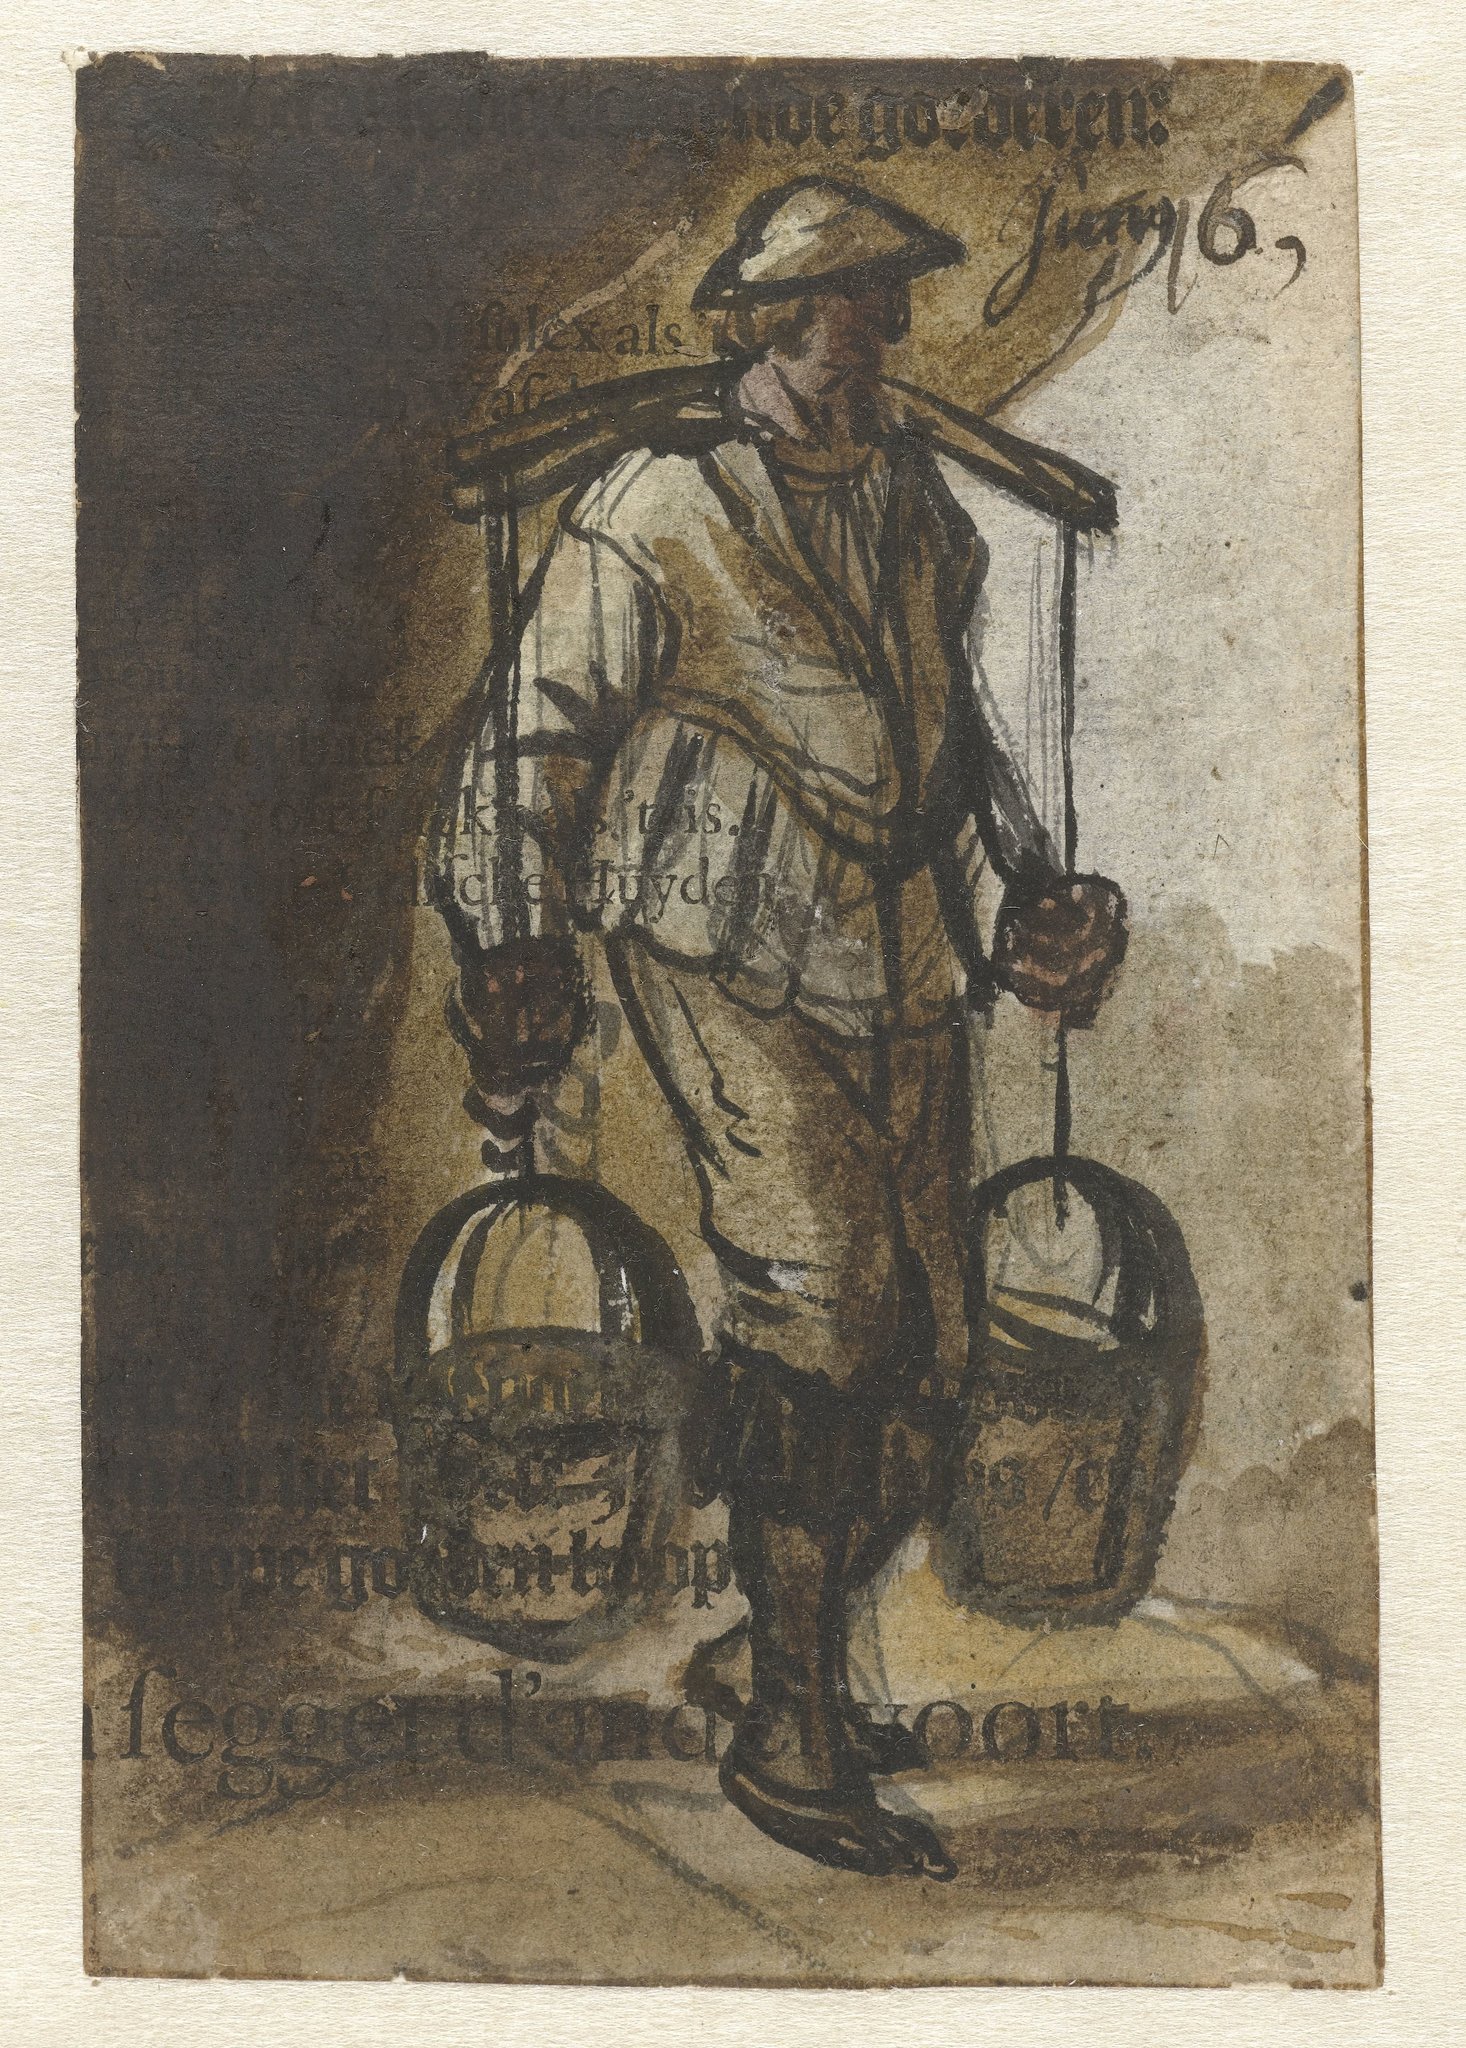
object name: drawing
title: De twaalf maanden van het jaar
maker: Anonymous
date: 1600-1699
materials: paper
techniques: brush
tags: june and its 'labours', carrying something with yoke